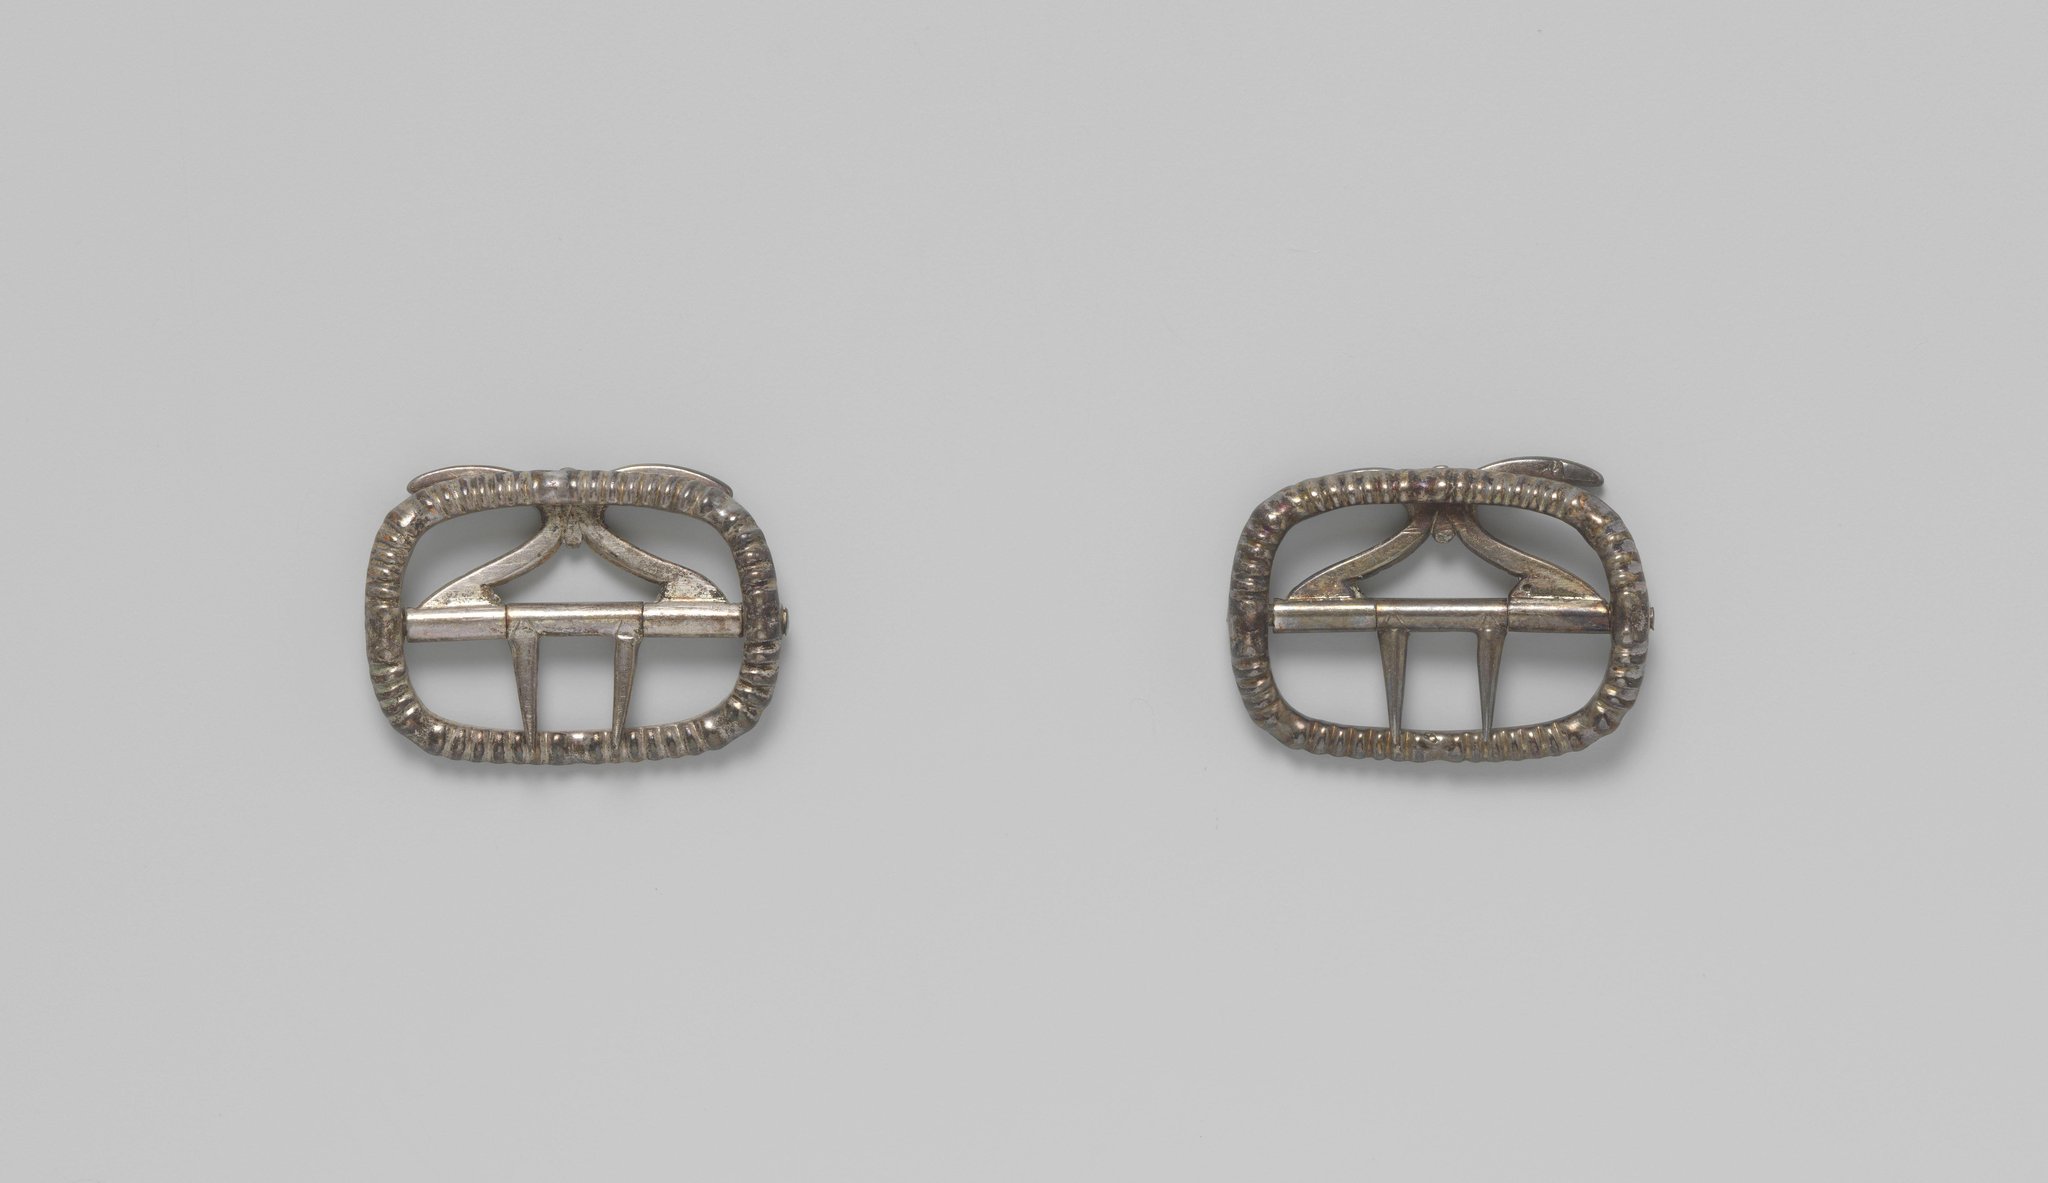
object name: broekgesp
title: Broekgesp met parelrand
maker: Anonymous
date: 1800-1900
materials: metal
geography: europe